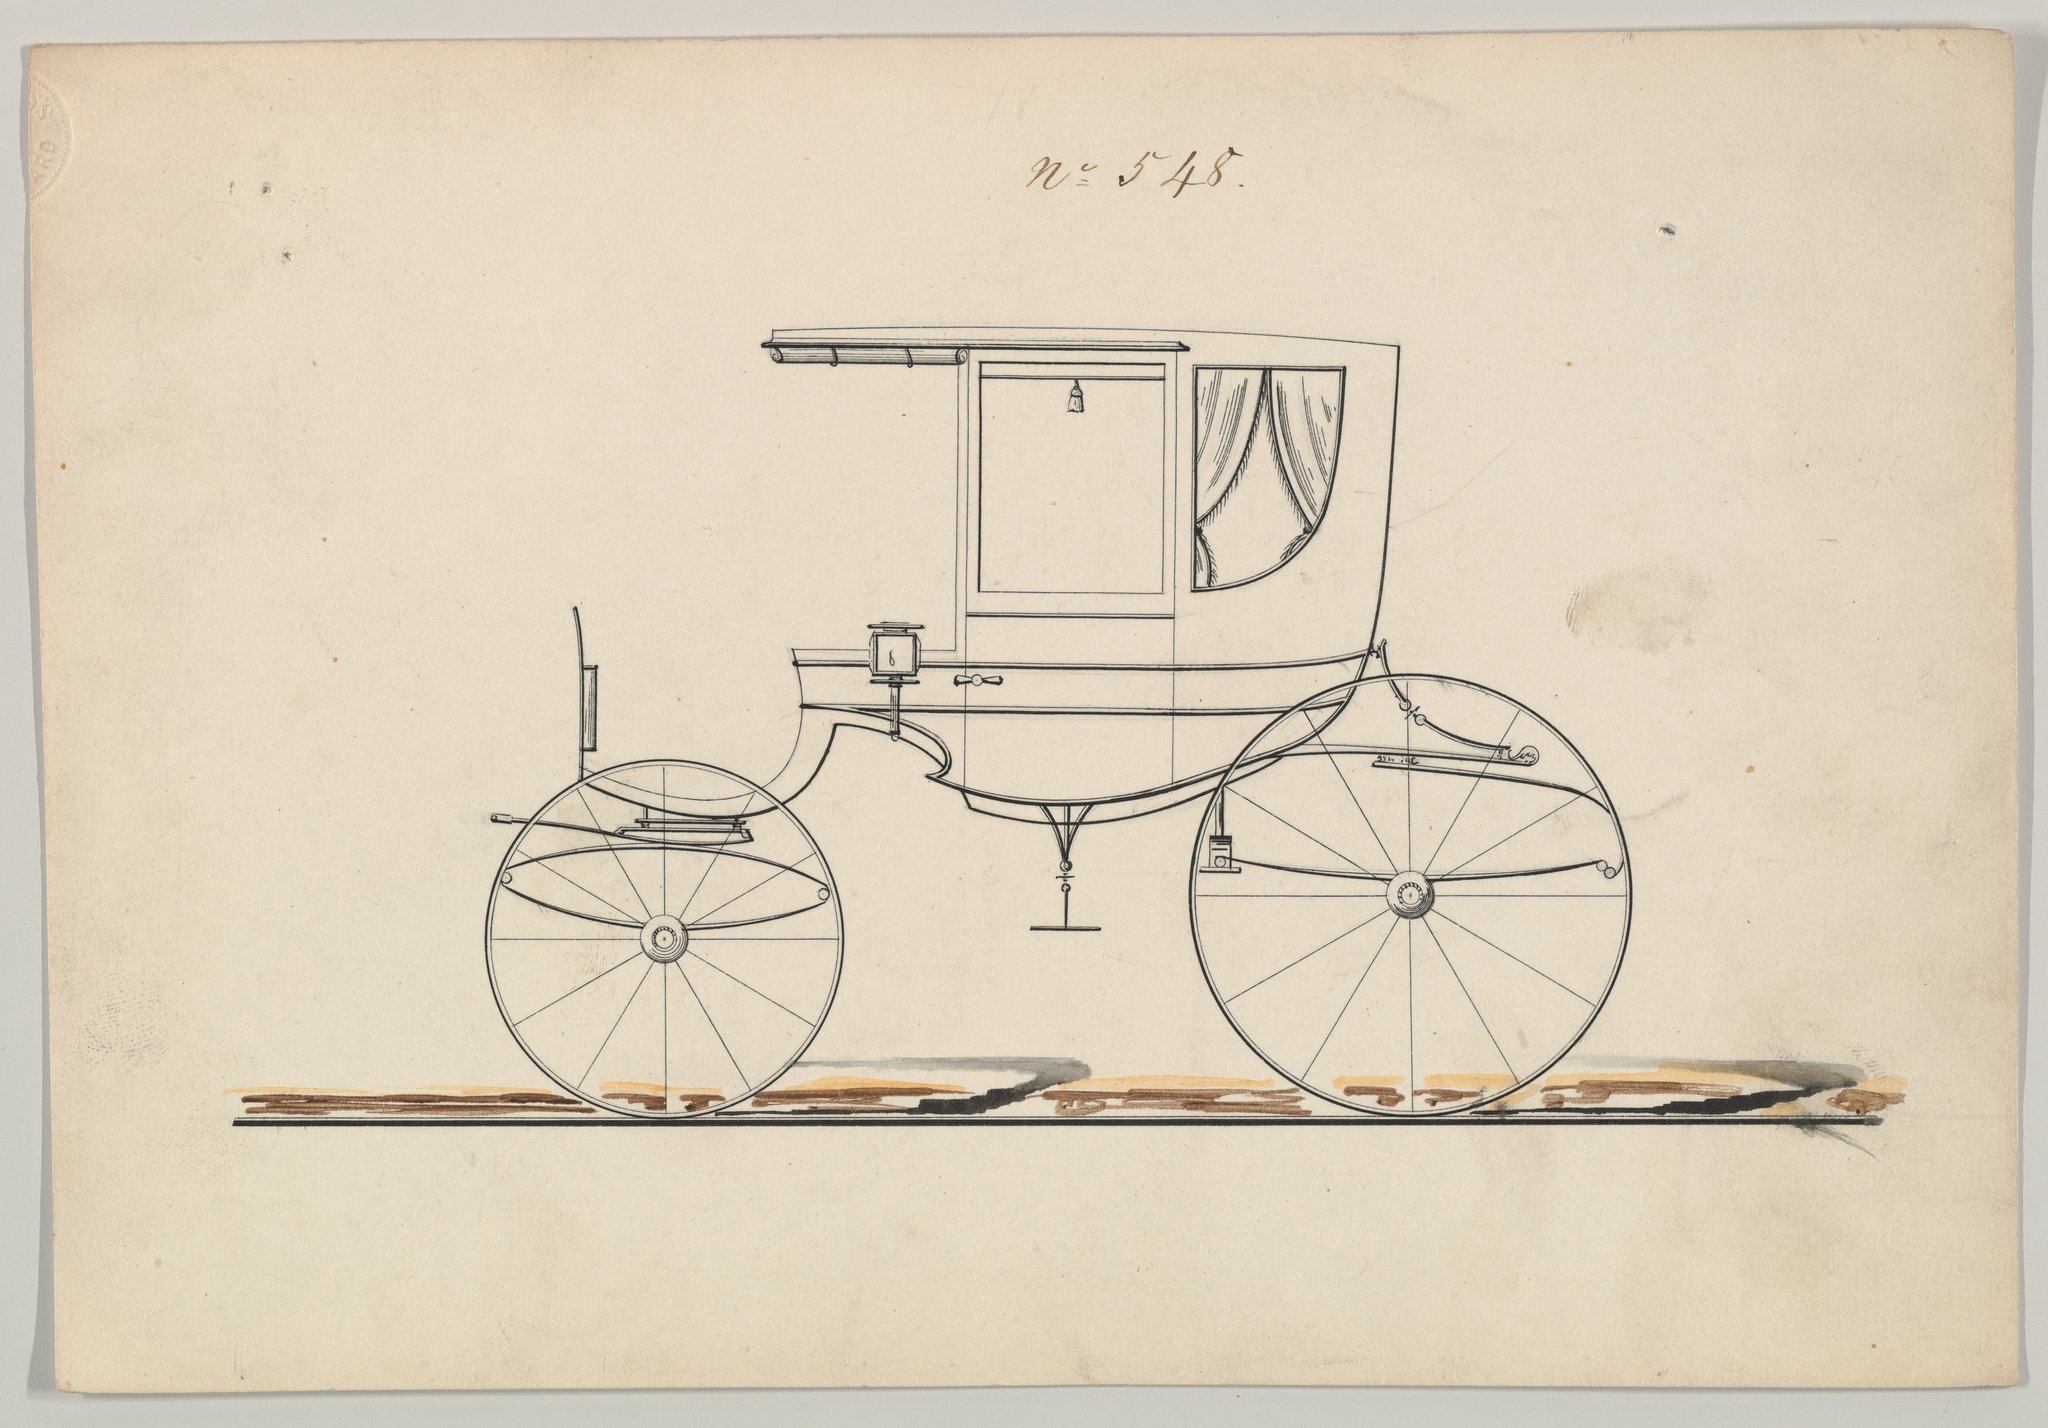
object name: drawing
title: Rockaway #548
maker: brewster & co.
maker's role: manufacturer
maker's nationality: american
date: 1850-1870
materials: ink, watercolor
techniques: pen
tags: carriages